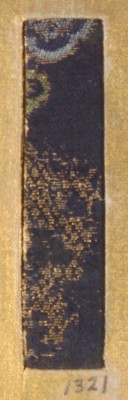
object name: piece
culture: japanese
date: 1701-1900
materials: silk